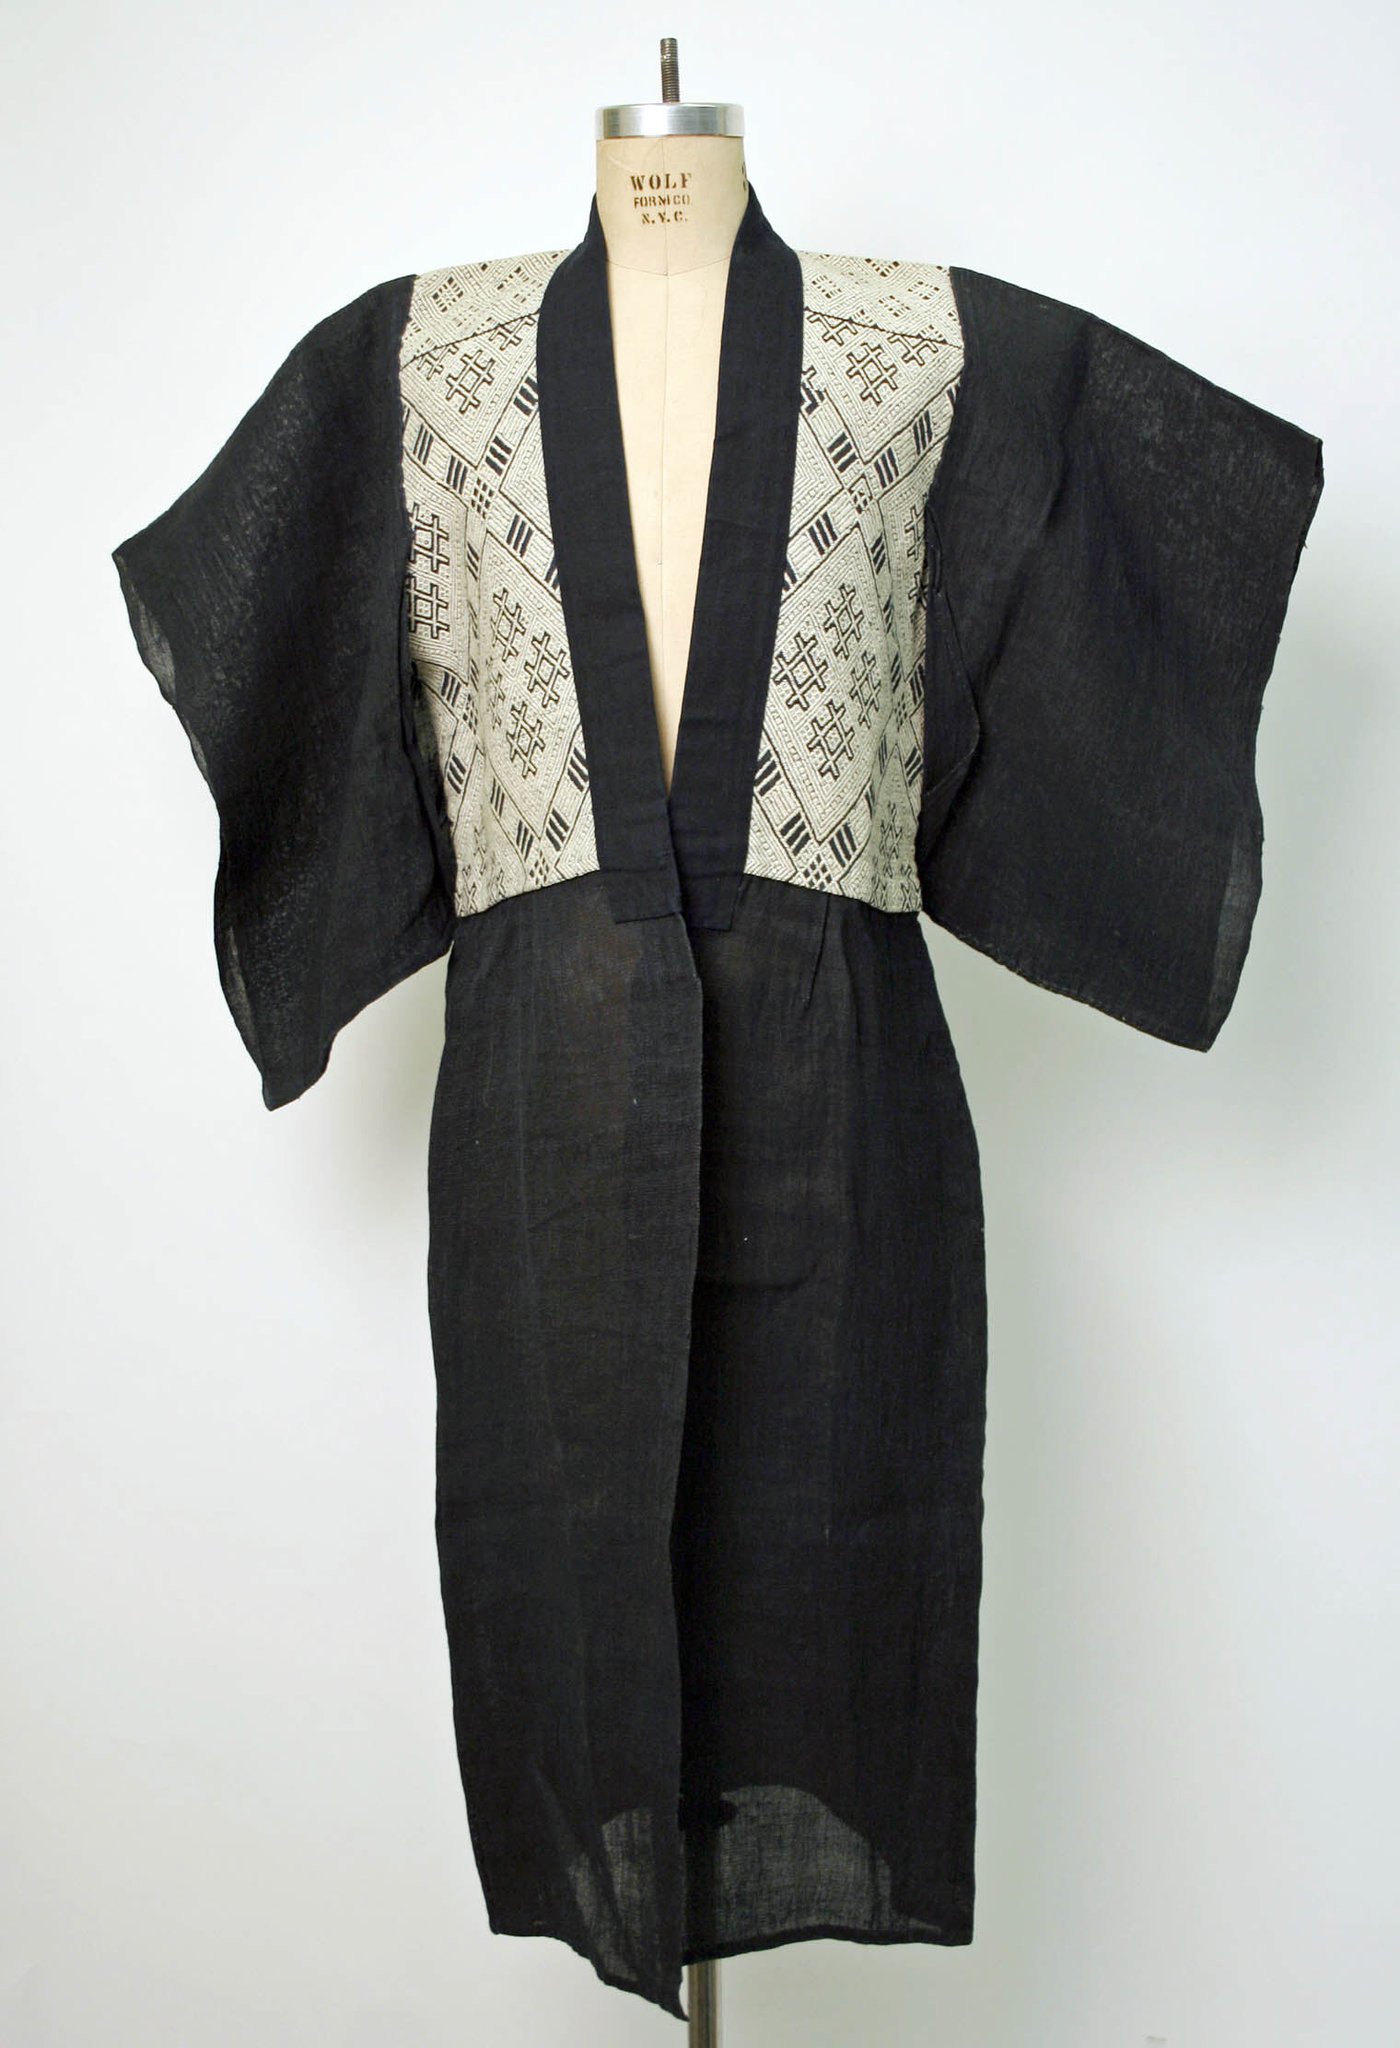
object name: kimono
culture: japanese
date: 1801-1900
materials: textile, cotton